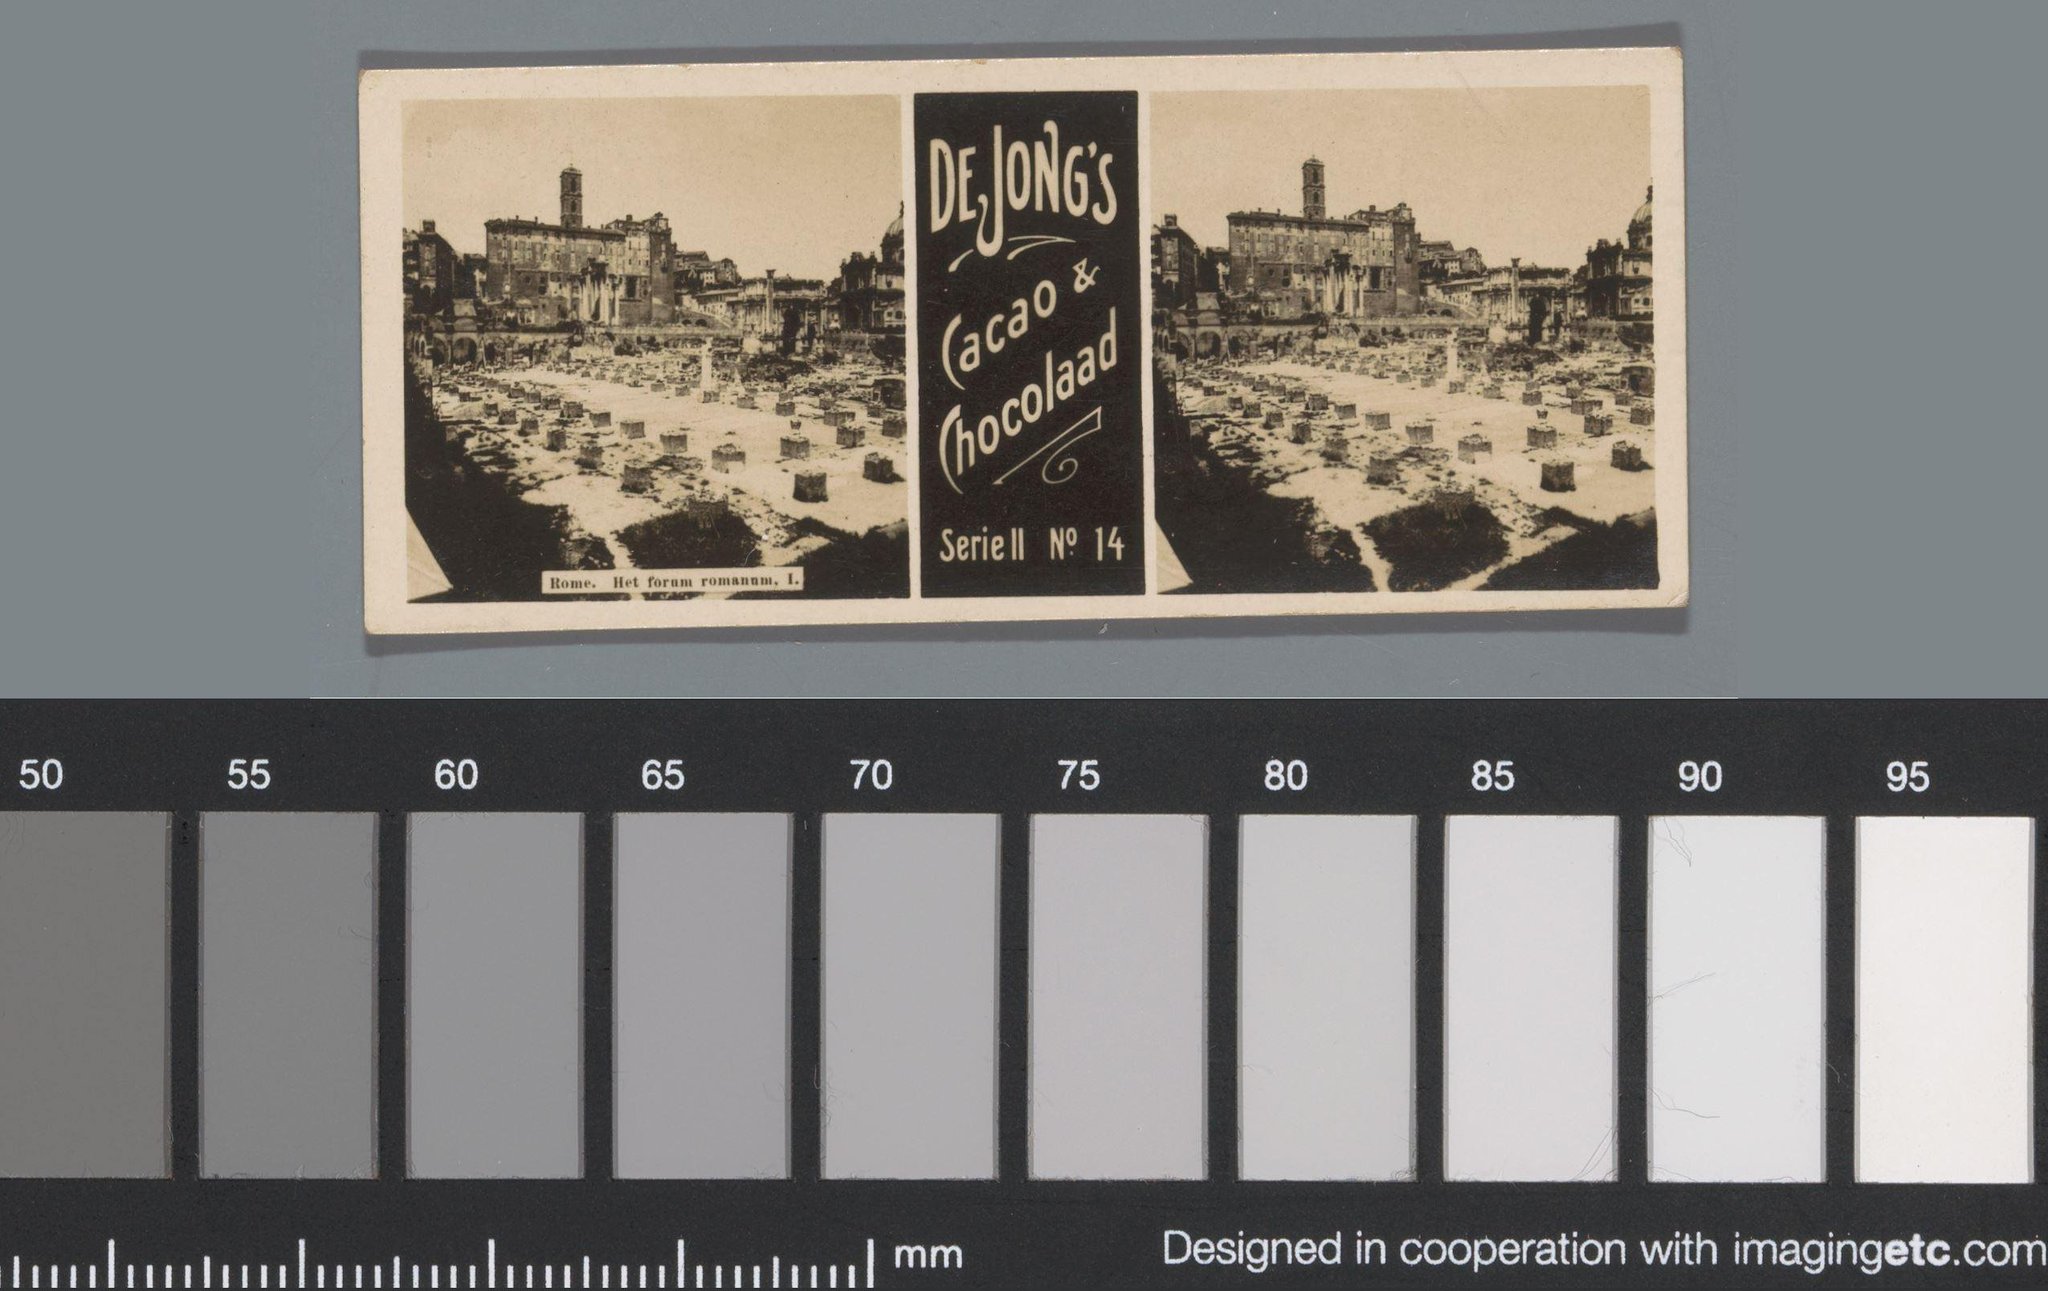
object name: stereograph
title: Gezicht op het Forum Romanum te Rome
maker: Anonymous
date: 1900-1910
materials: cardboard, photographic support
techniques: gelatin silver print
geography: rome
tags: landscape with ruins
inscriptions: number: ‘Serie II No. 14’, inscription: ‘De Jong's Cacao & Chocolaad’